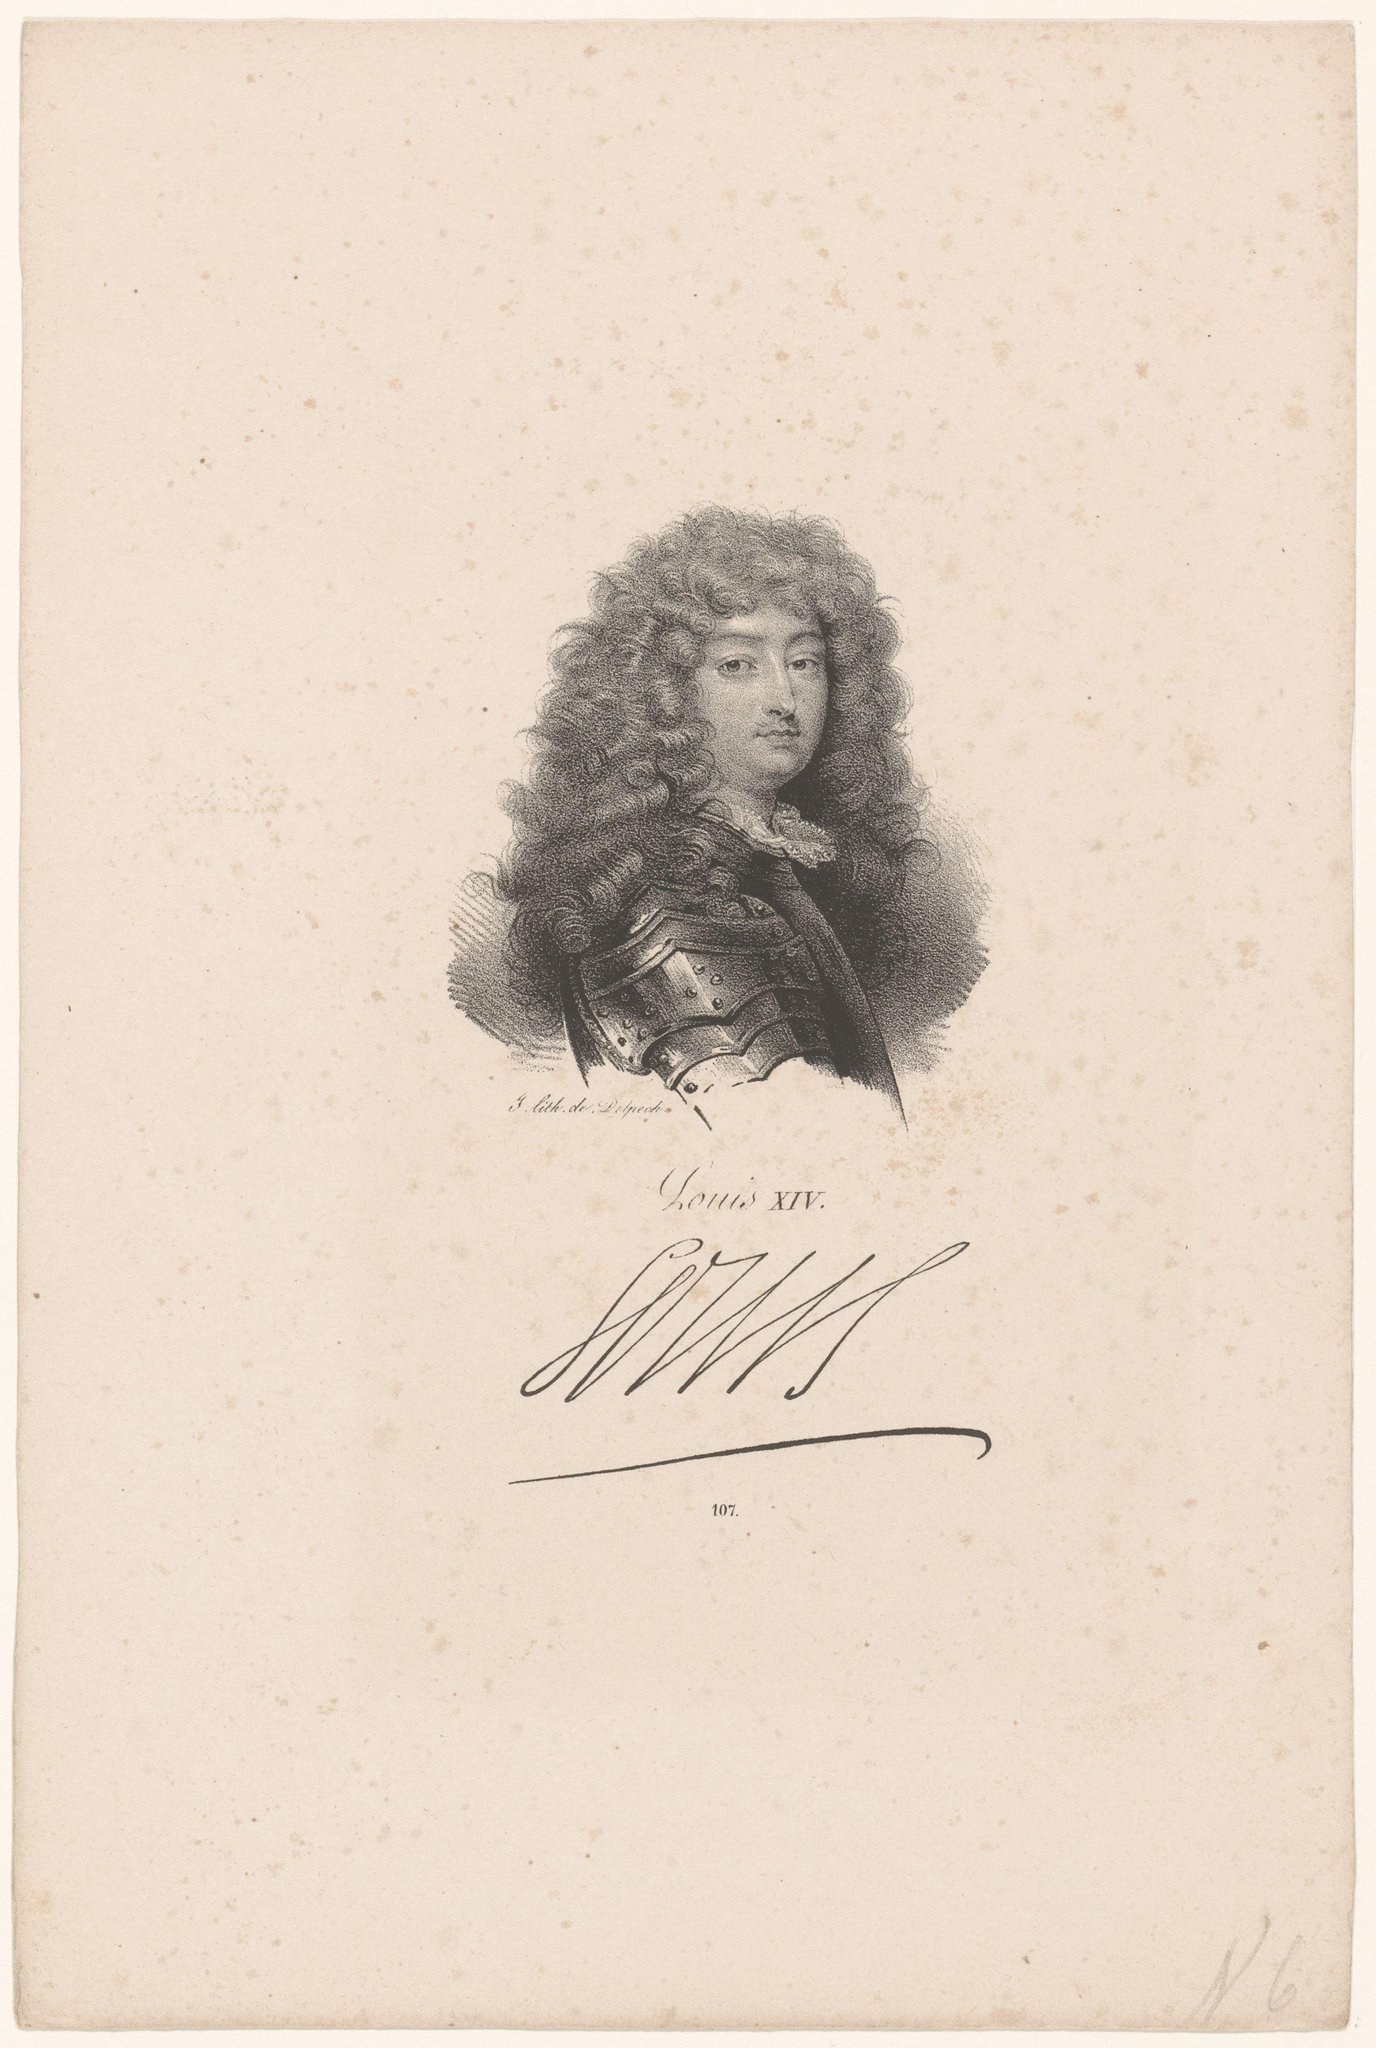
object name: print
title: Portret van Lodewijk XIV van Frankrijk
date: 1818-1842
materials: paper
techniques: lithograph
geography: paris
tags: lodewijk xiv (koning van frankrijk), historical persons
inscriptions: collector's mark: Lugt 2228a